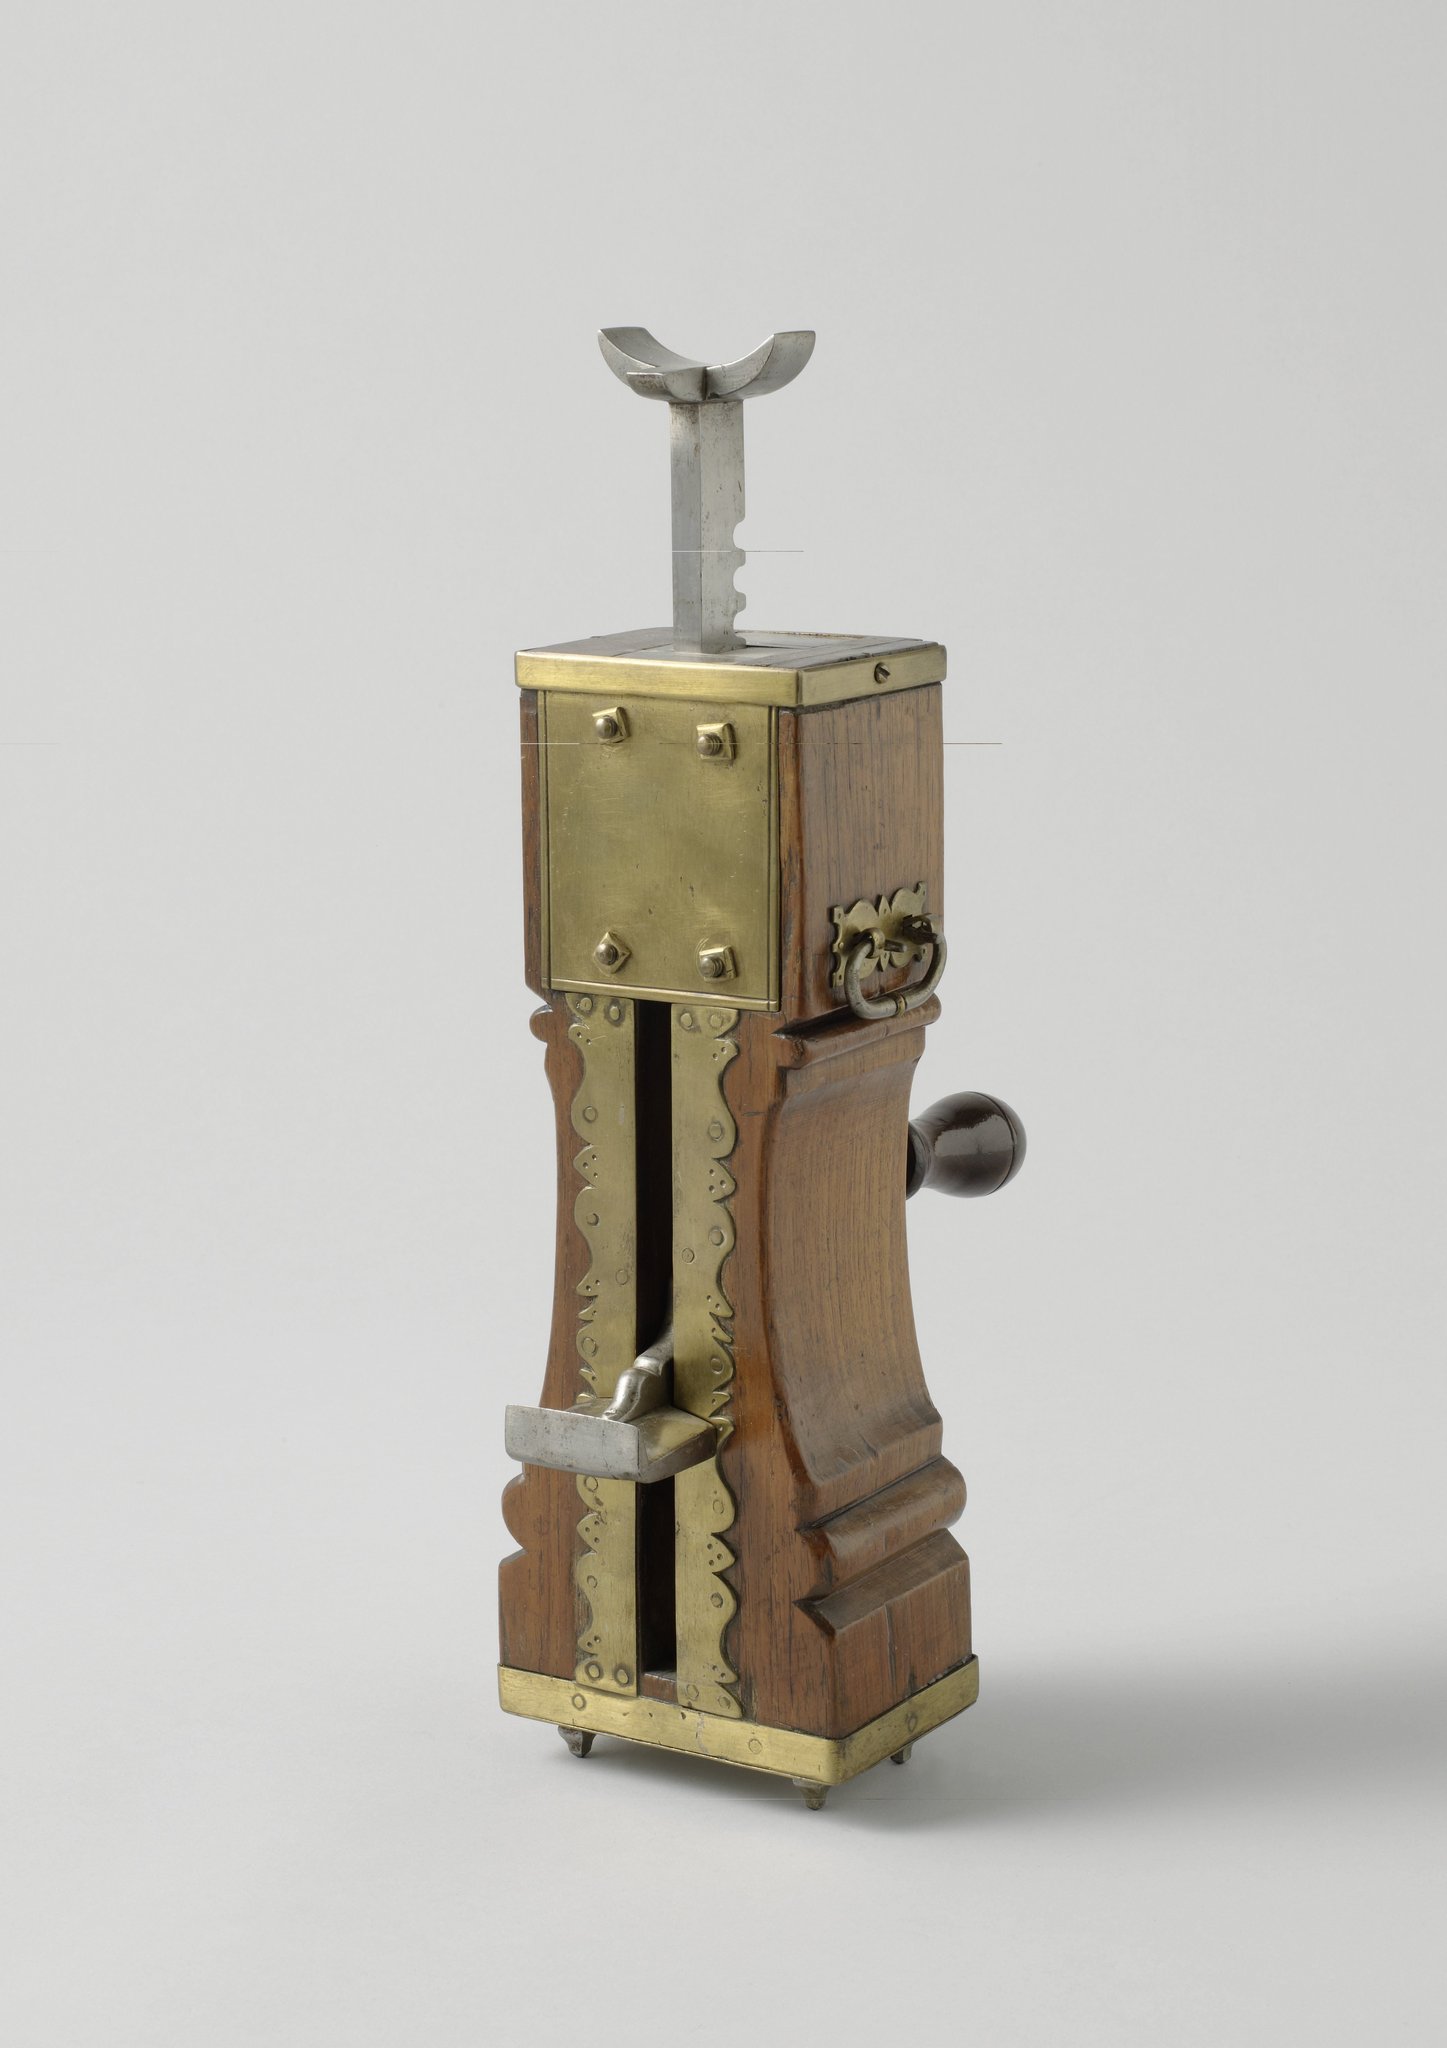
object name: demonstration model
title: Model of an Ordinary Jack Screw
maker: Anonymous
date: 1780-1807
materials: brass, iron, wood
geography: netherlands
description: Model van een gewone dommekracht, versierd met beslag. Het model wordt bediend met een zwengel. Aan de andere kant zit een krik en bovenop een T-vormige krik. Het mechaniek, dat werkt met een wormschroef, is aan het gezicht onttrokken; aan de voorkant zit een kijkgaatje. Aan de zijden twee handvaten.